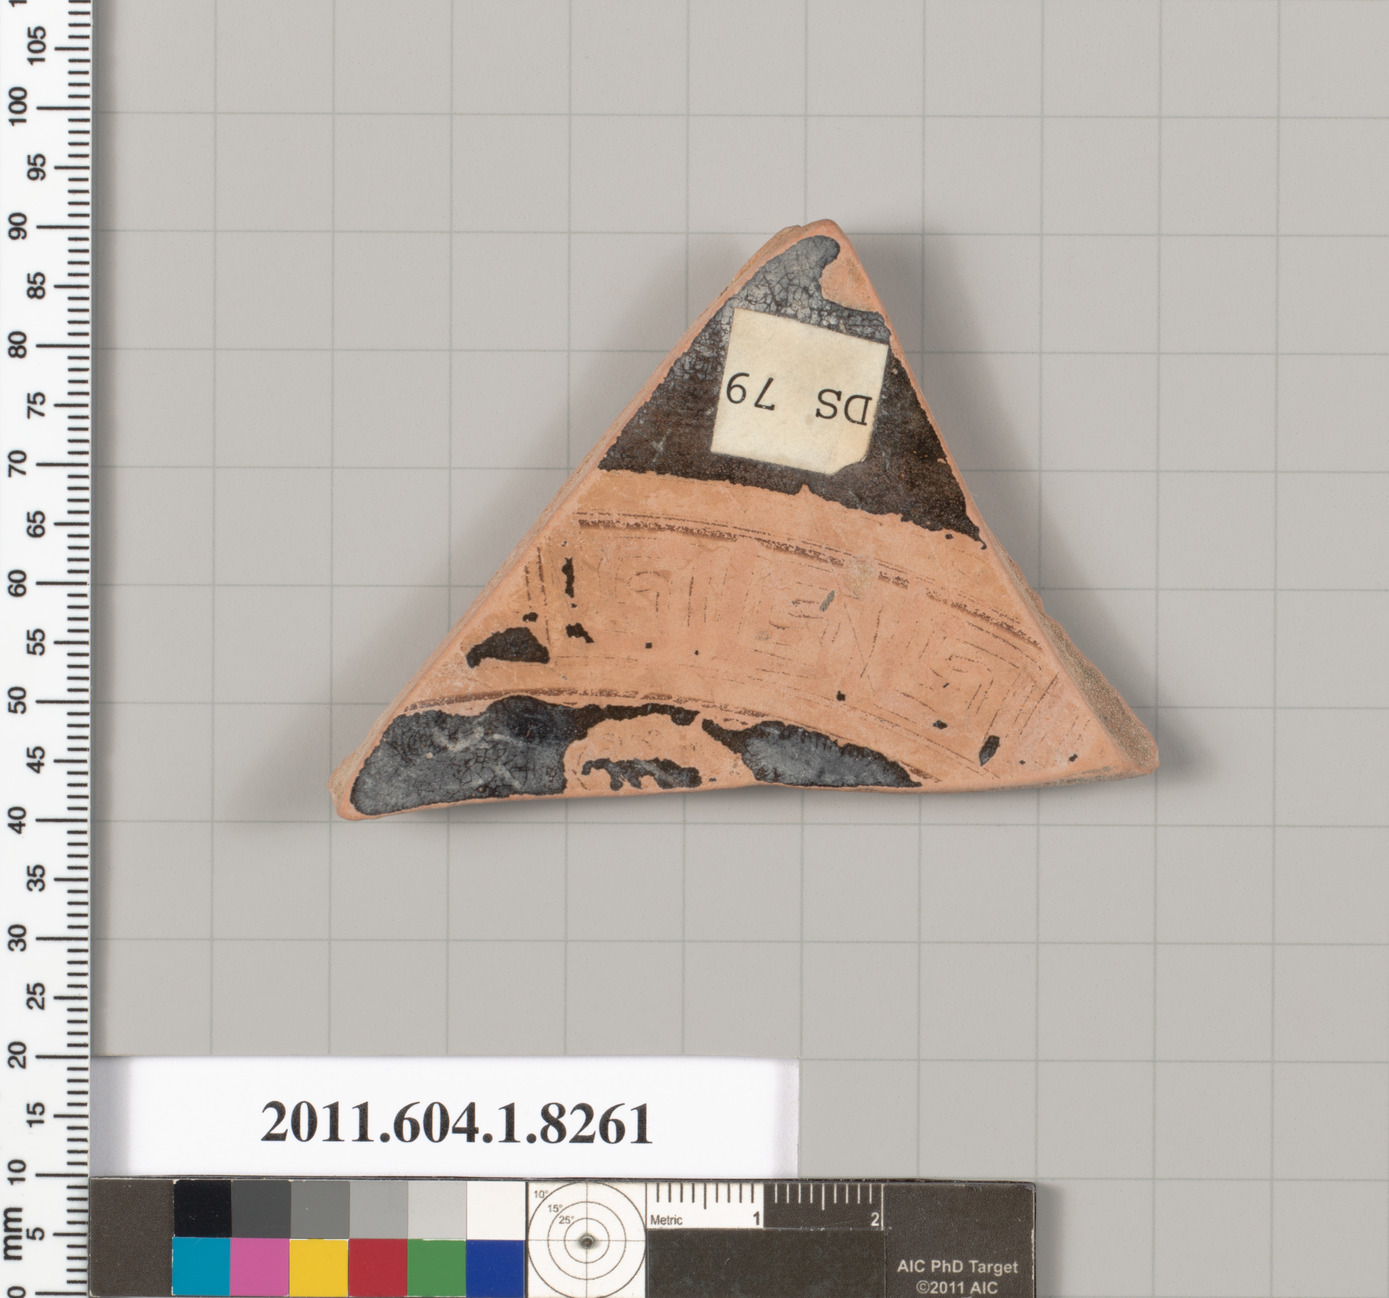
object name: kylix fragment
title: Terracotta fragment of a kylix (drinking cup)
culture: greek, attic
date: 375-351 BCE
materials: terracotta